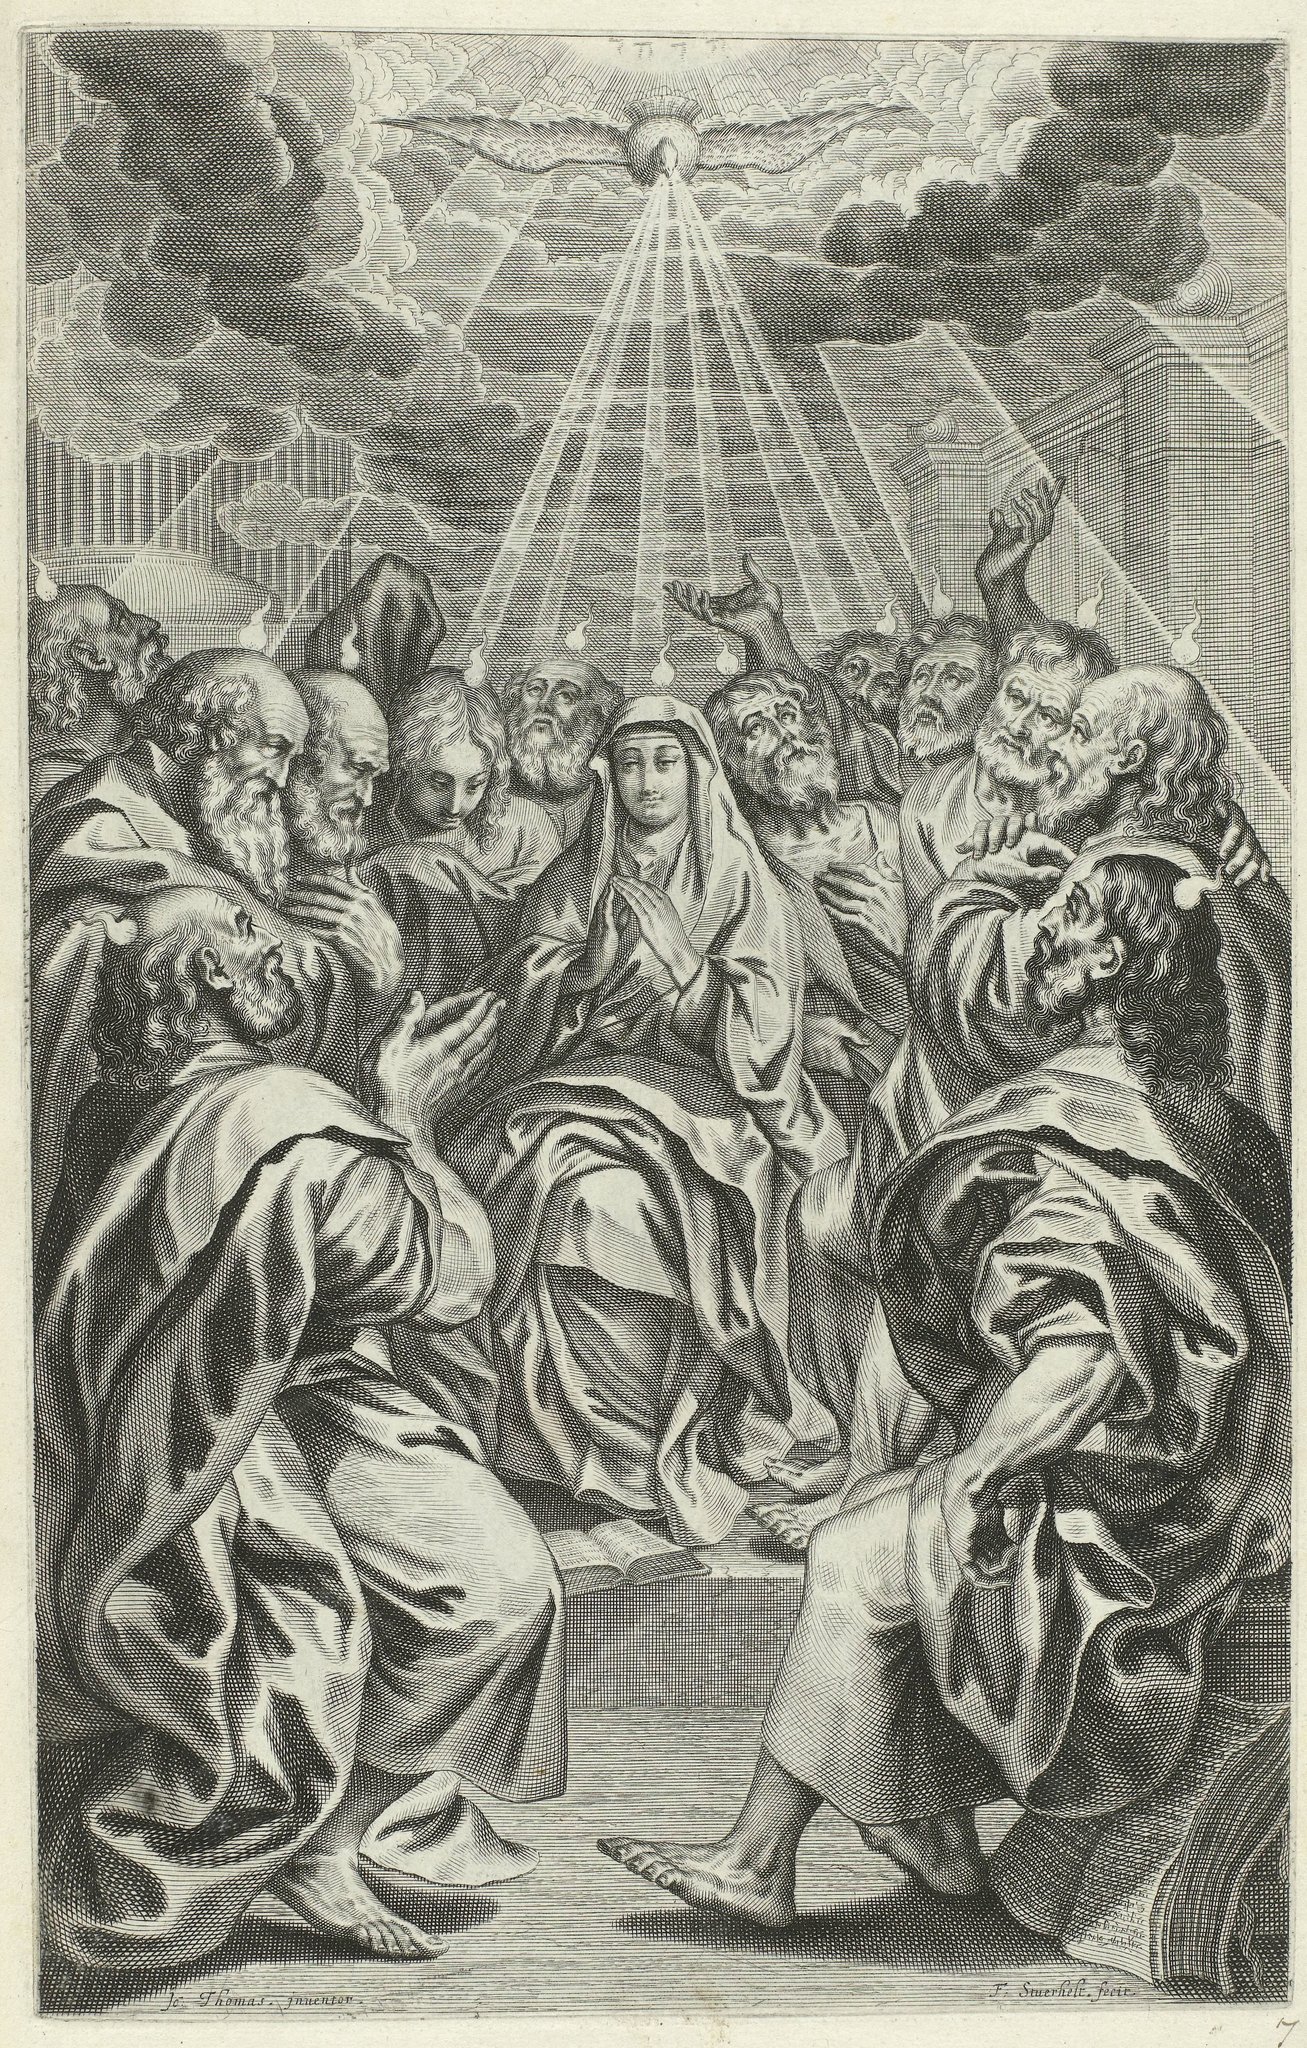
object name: album leaf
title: Leven van Christus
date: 1600-1652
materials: paper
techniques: engraving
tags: pentecost: the holy ghost descends upon (mary and) the apostles, sometimes paul and/or representatives of the nations present (acts 2:1-4)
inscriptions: collector's mark: Lugt 2760, collector's mark: Lugt 2228, inscription: ‘7’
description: In het midden zit Maria met gevouwen handen. Om haar heen staan de apostelen met gevouwen of opgeheven handen. Boven elk hoofd een vlam. Vanuit de hemel daalt de Heilige Geest in de gedaante van een duif, stralen uitzendend naar alle aanwezigen. Op de grond twee openliggende boeken. De prent maakt deel uit van een album.